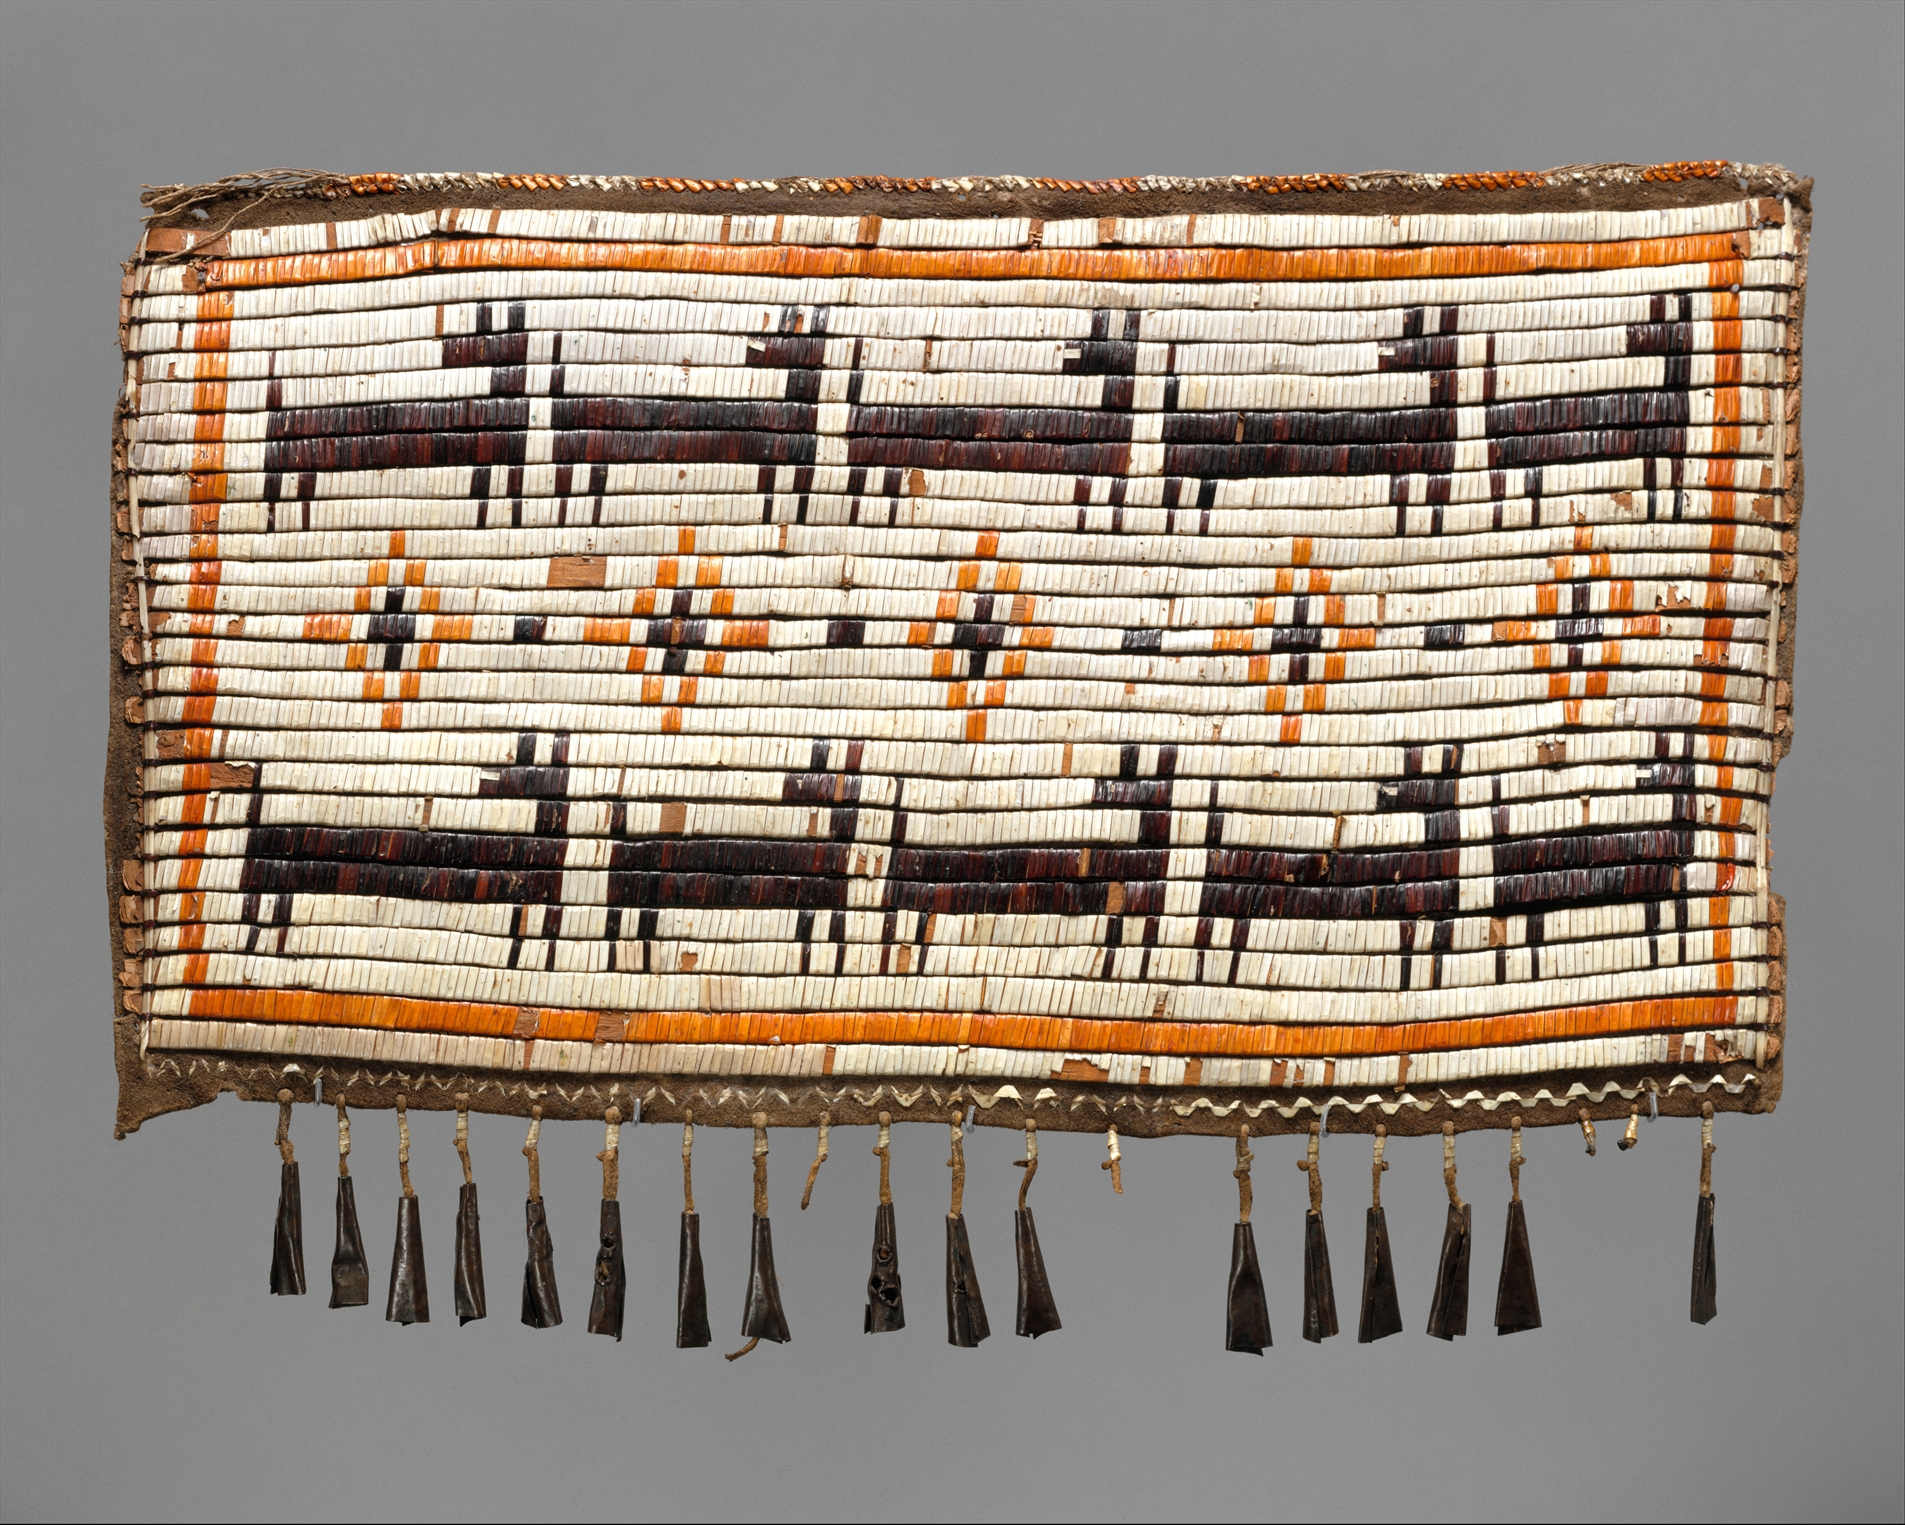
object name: panel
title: Cradleboard Cover Panel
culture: eastern sioux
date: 1810-1830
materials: metal, skin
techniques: tanning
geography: united states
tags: animals